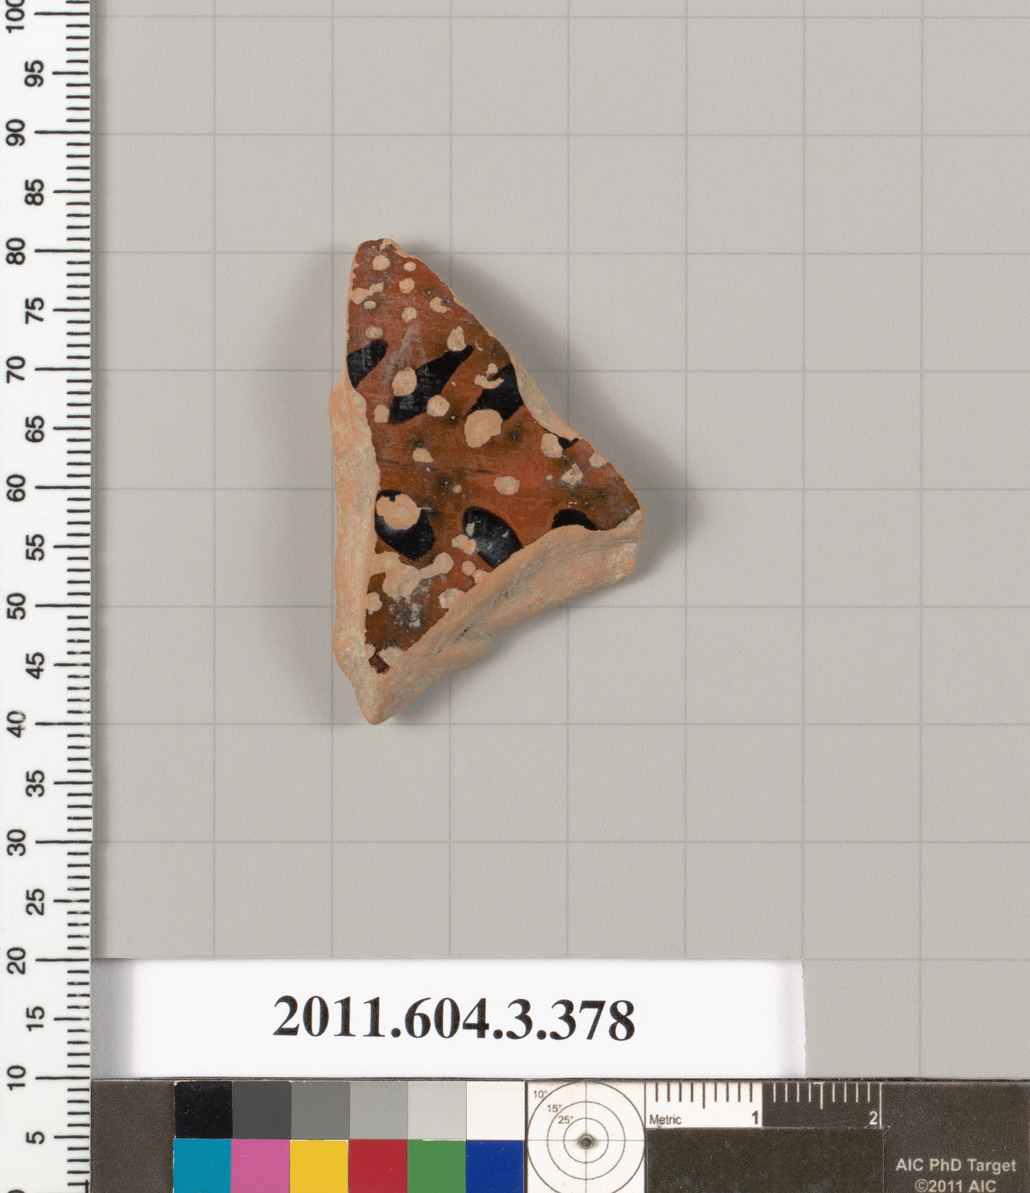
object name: neck amphora fragment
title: Terracotta fragment of a neck-amphora (jar)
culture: greek, attic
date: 500-468 BCE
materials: terracotta